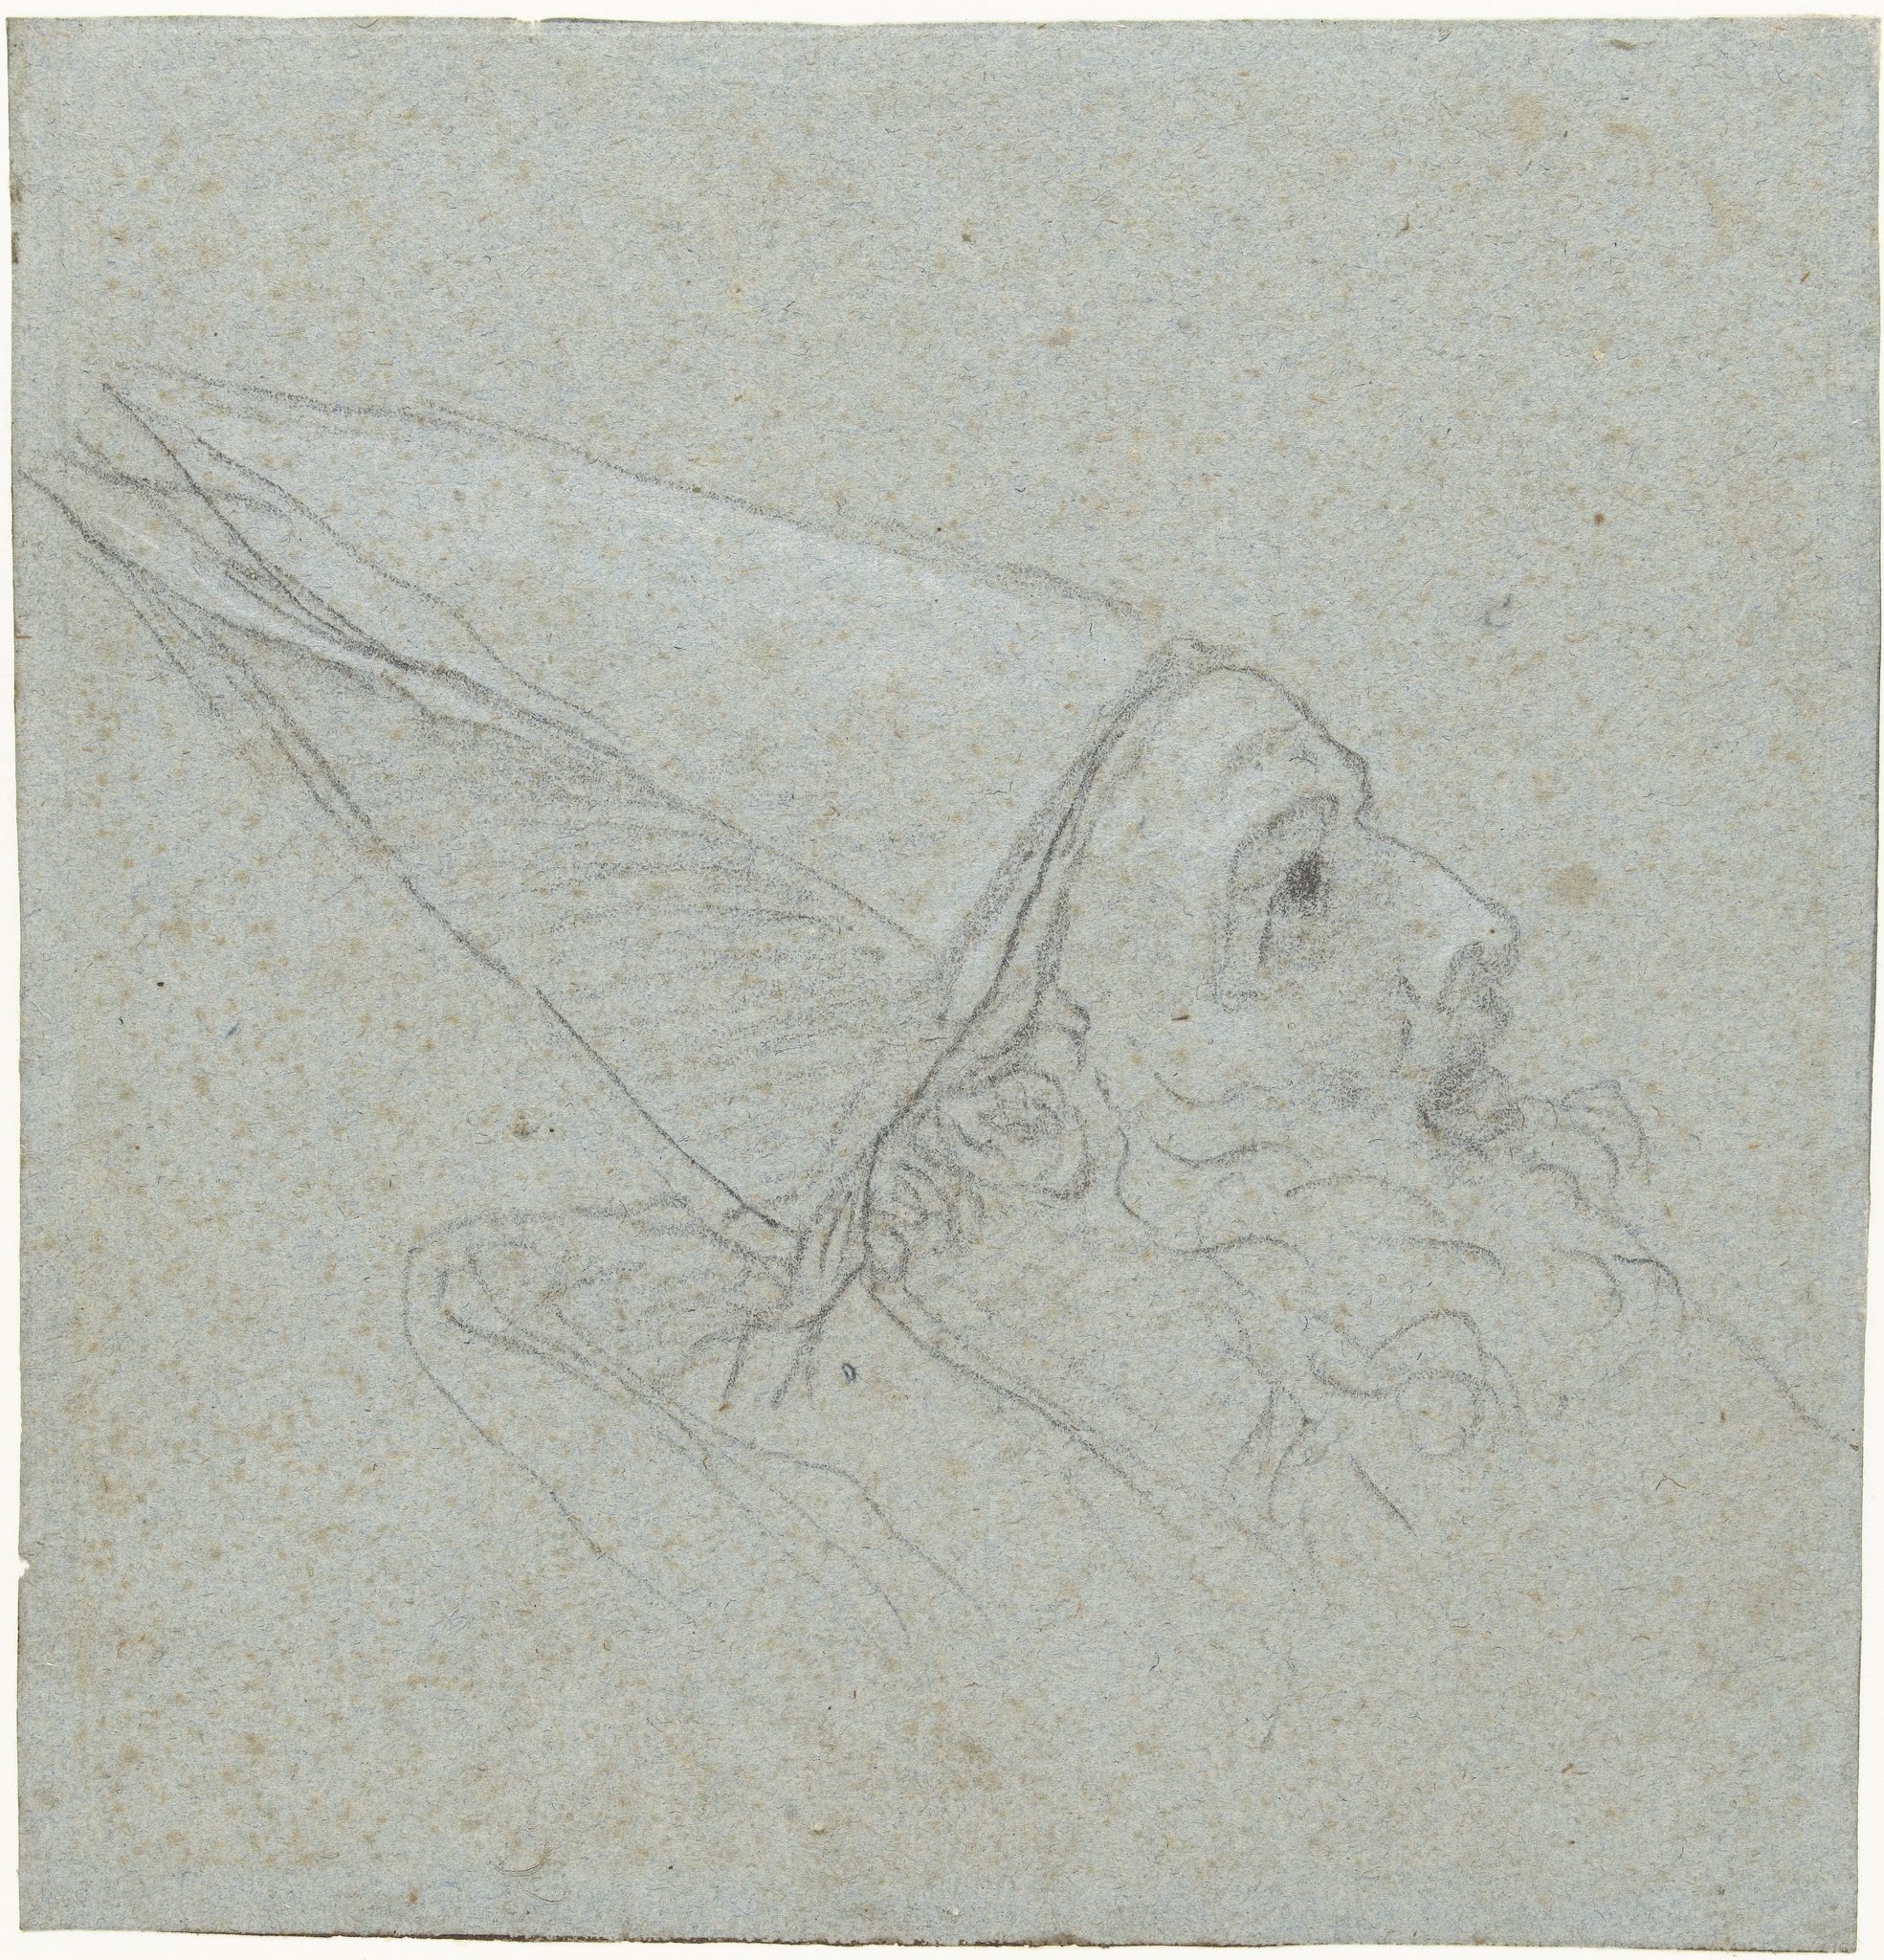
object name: drawing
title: Hoofd van een opziende bisschop, en profil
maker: carlo maratta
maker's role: draughtsman, painter, print maker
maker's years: 1625-1713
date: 1680-1690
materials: chalk, paper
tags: archbishop, bishop, etc. (roman catholic)